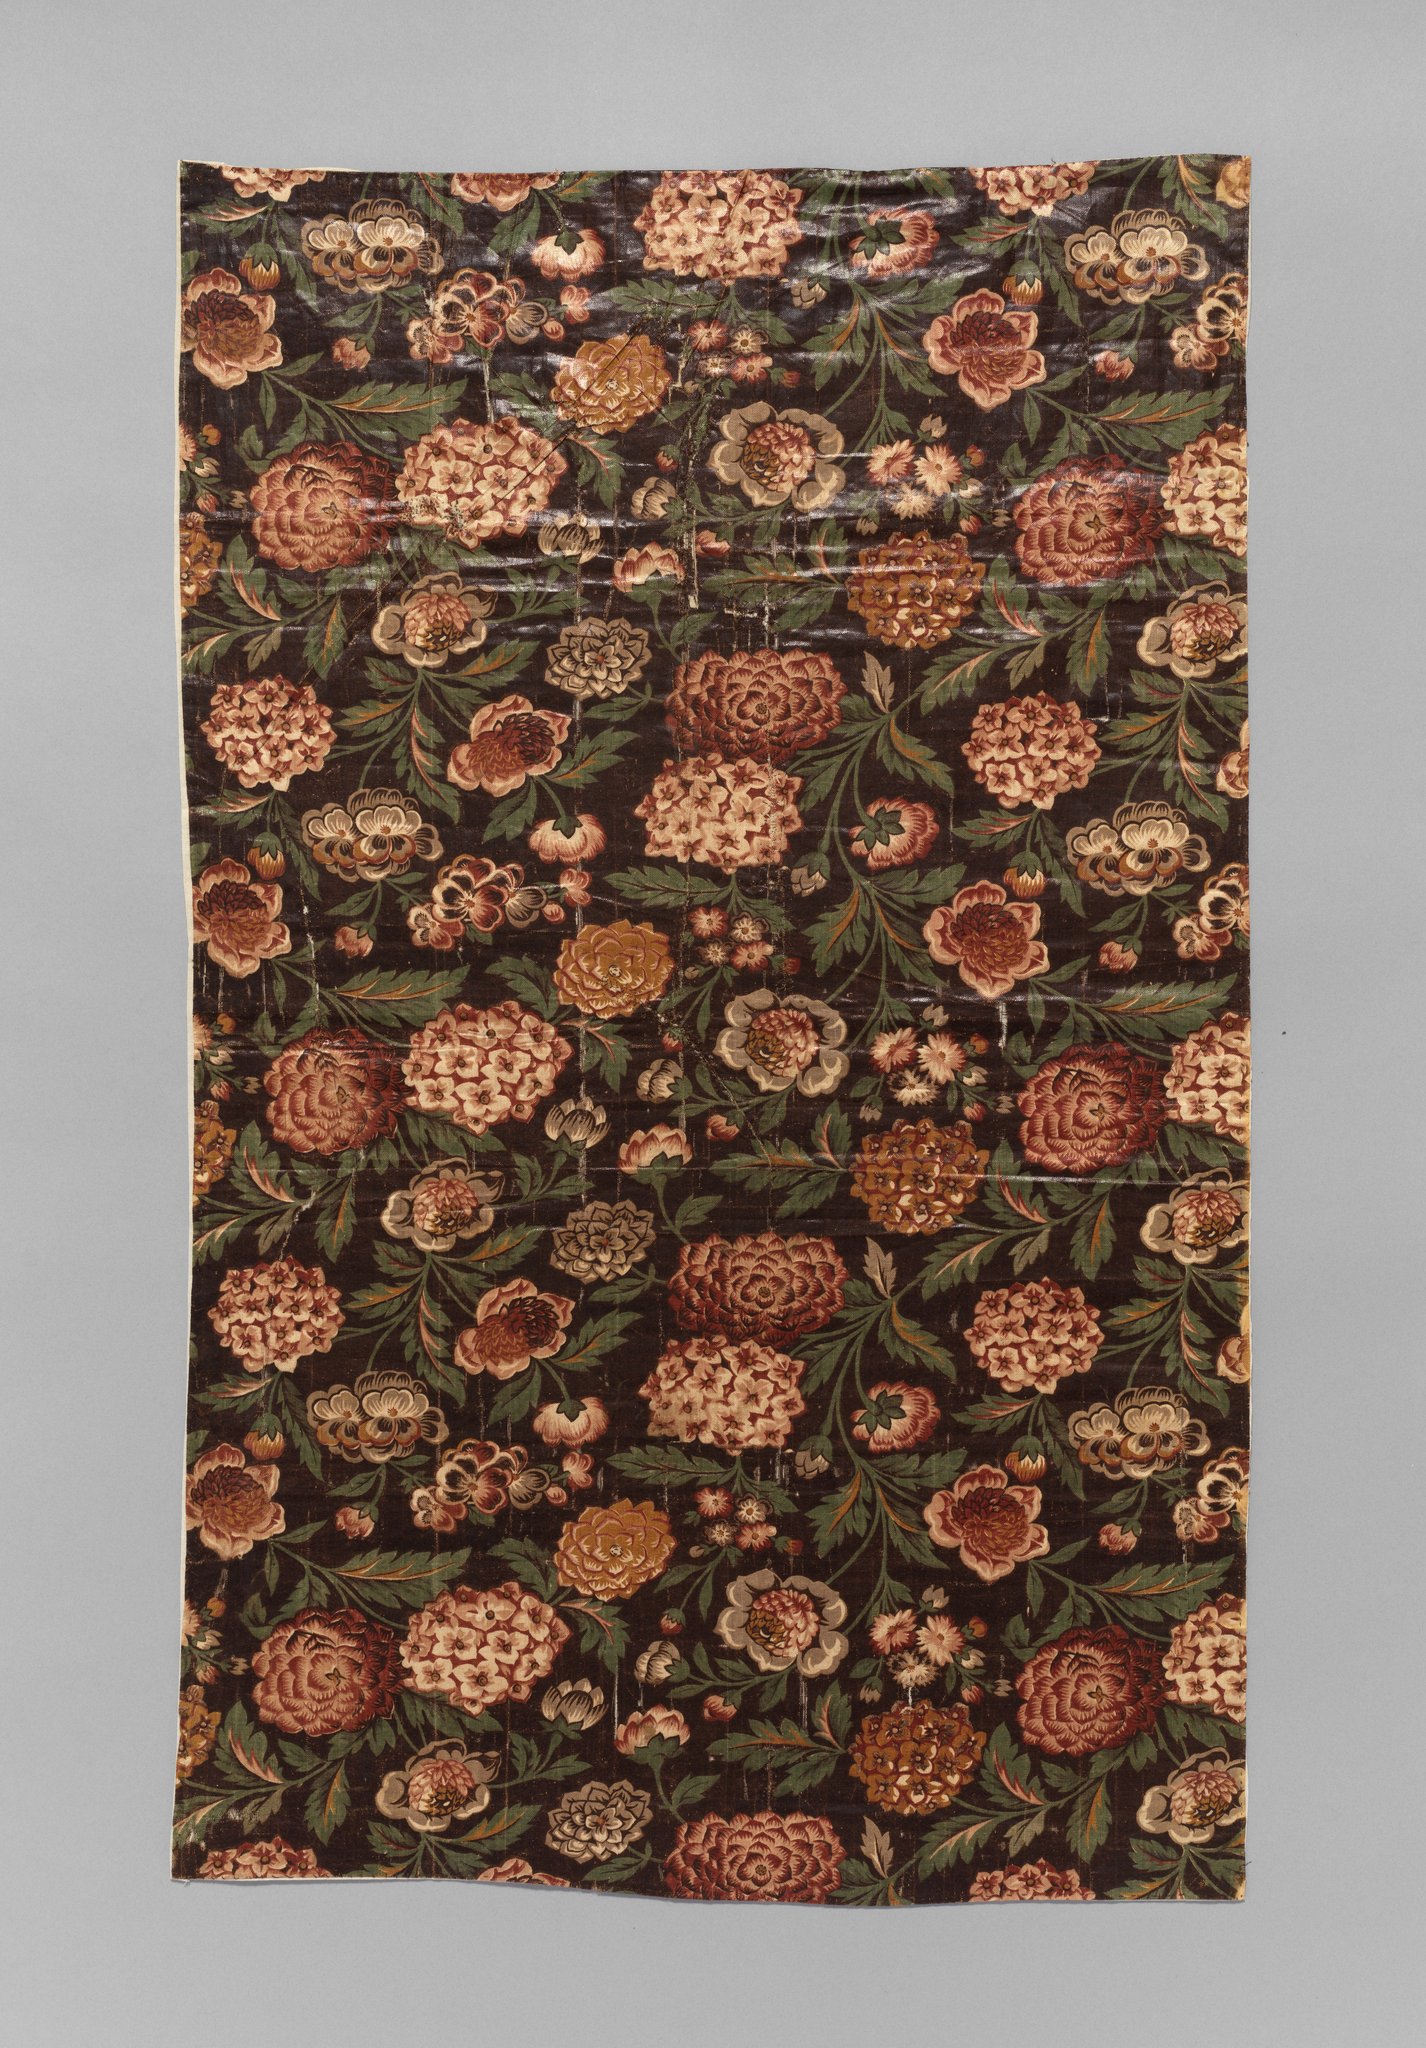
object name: piece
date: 1850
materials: cotton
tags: flowers